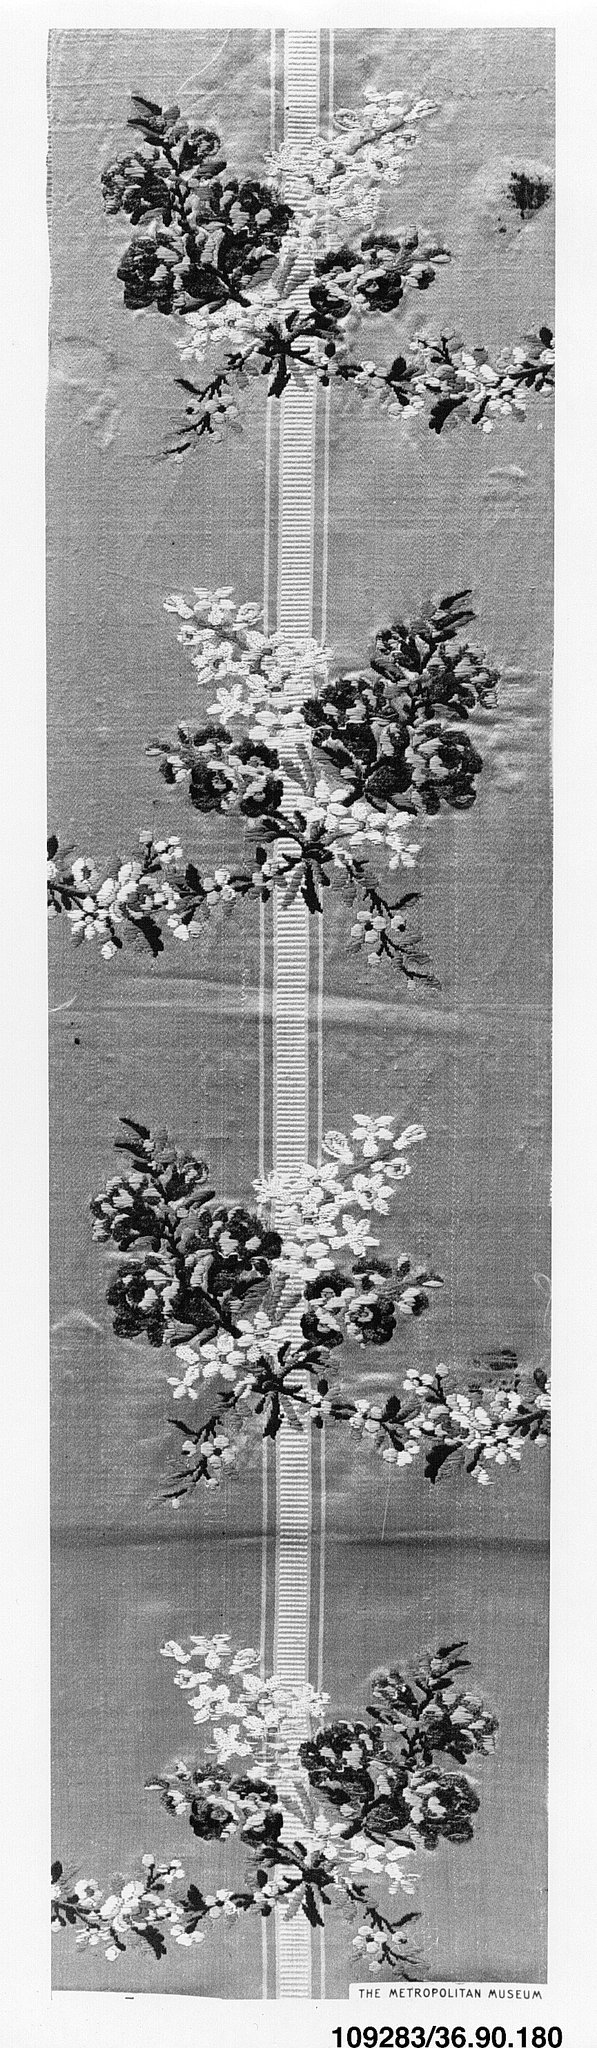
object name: piece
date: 1701-1800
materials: silk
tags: flowers,leaves